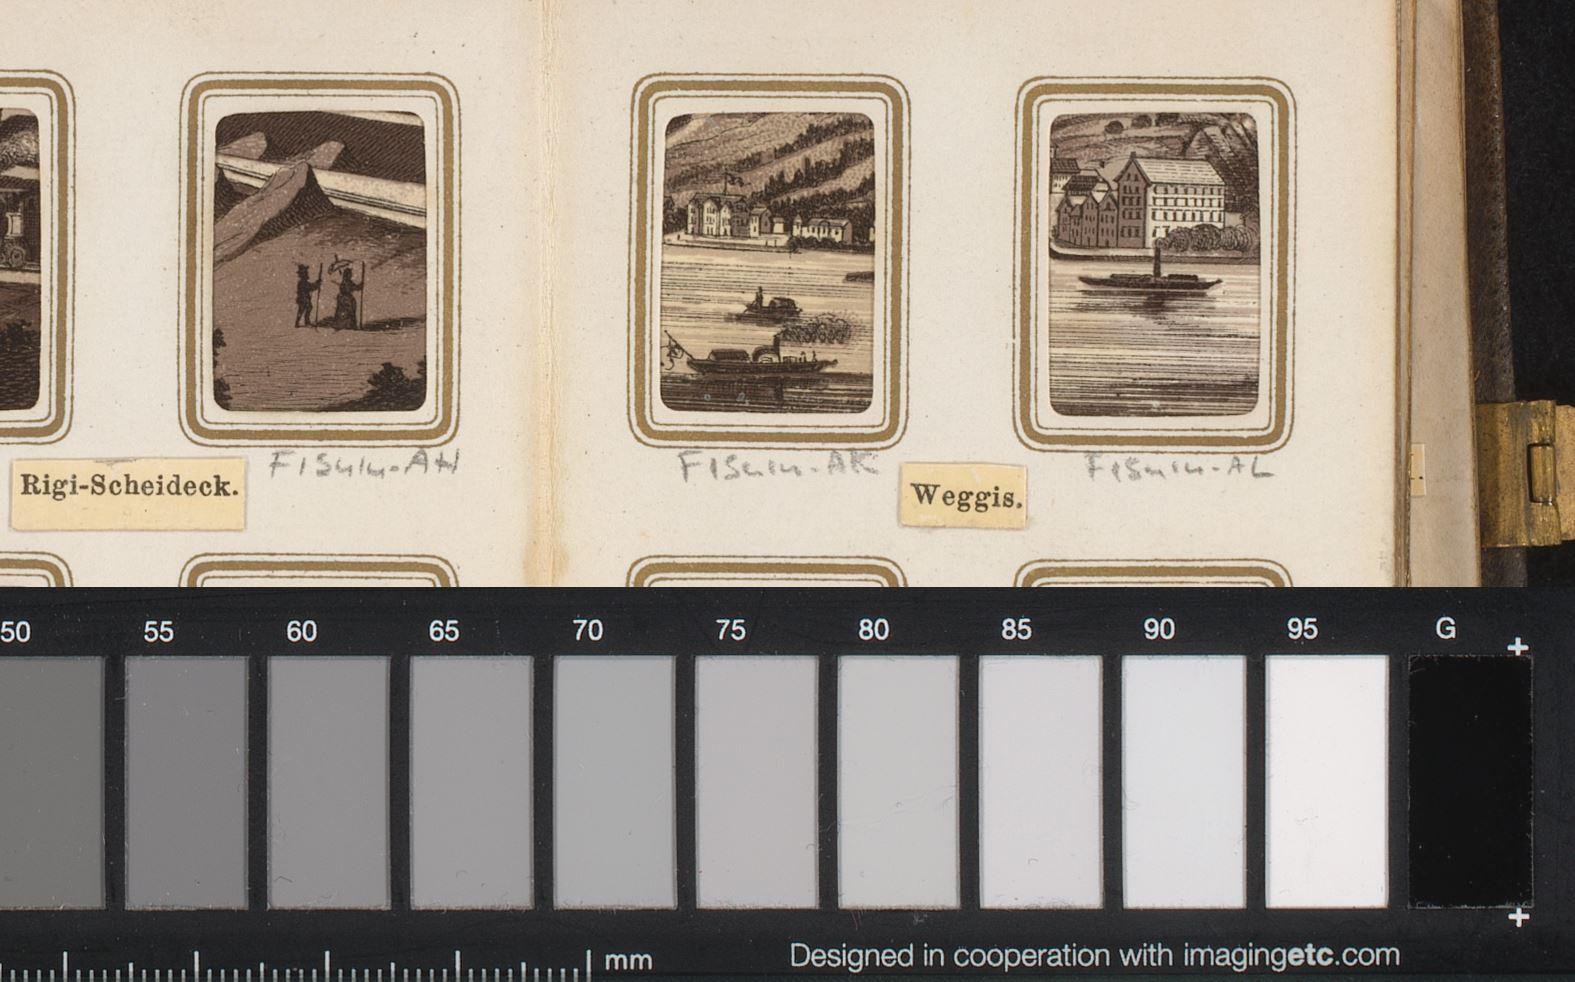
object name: album leaf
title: Weggis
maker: Anonymous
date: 1851-1910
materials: paper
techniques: lithograph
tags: ships (in general)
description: Deze prent maakt deel uit van een album.